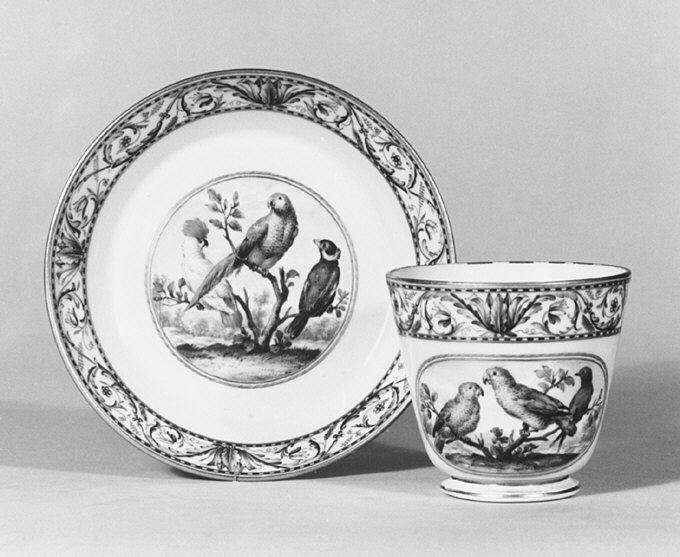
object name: coffee cup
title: Coffee cup (part of a service)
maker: meissen manufactory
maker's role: manufactory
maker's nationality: german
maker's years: 1710-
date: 1780-1785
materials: hard paste porcelain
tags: birds,flowers